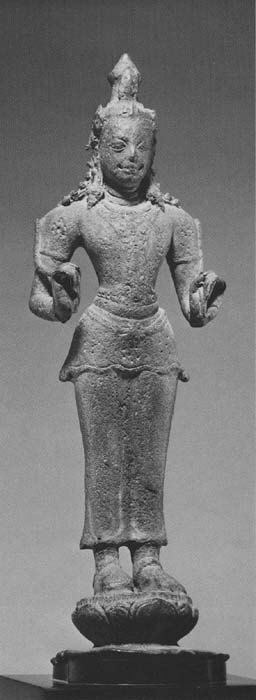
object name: figure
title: Surya, the God of the Sun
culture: indonesian, javanese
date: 801-900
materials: bronze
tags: hinduism